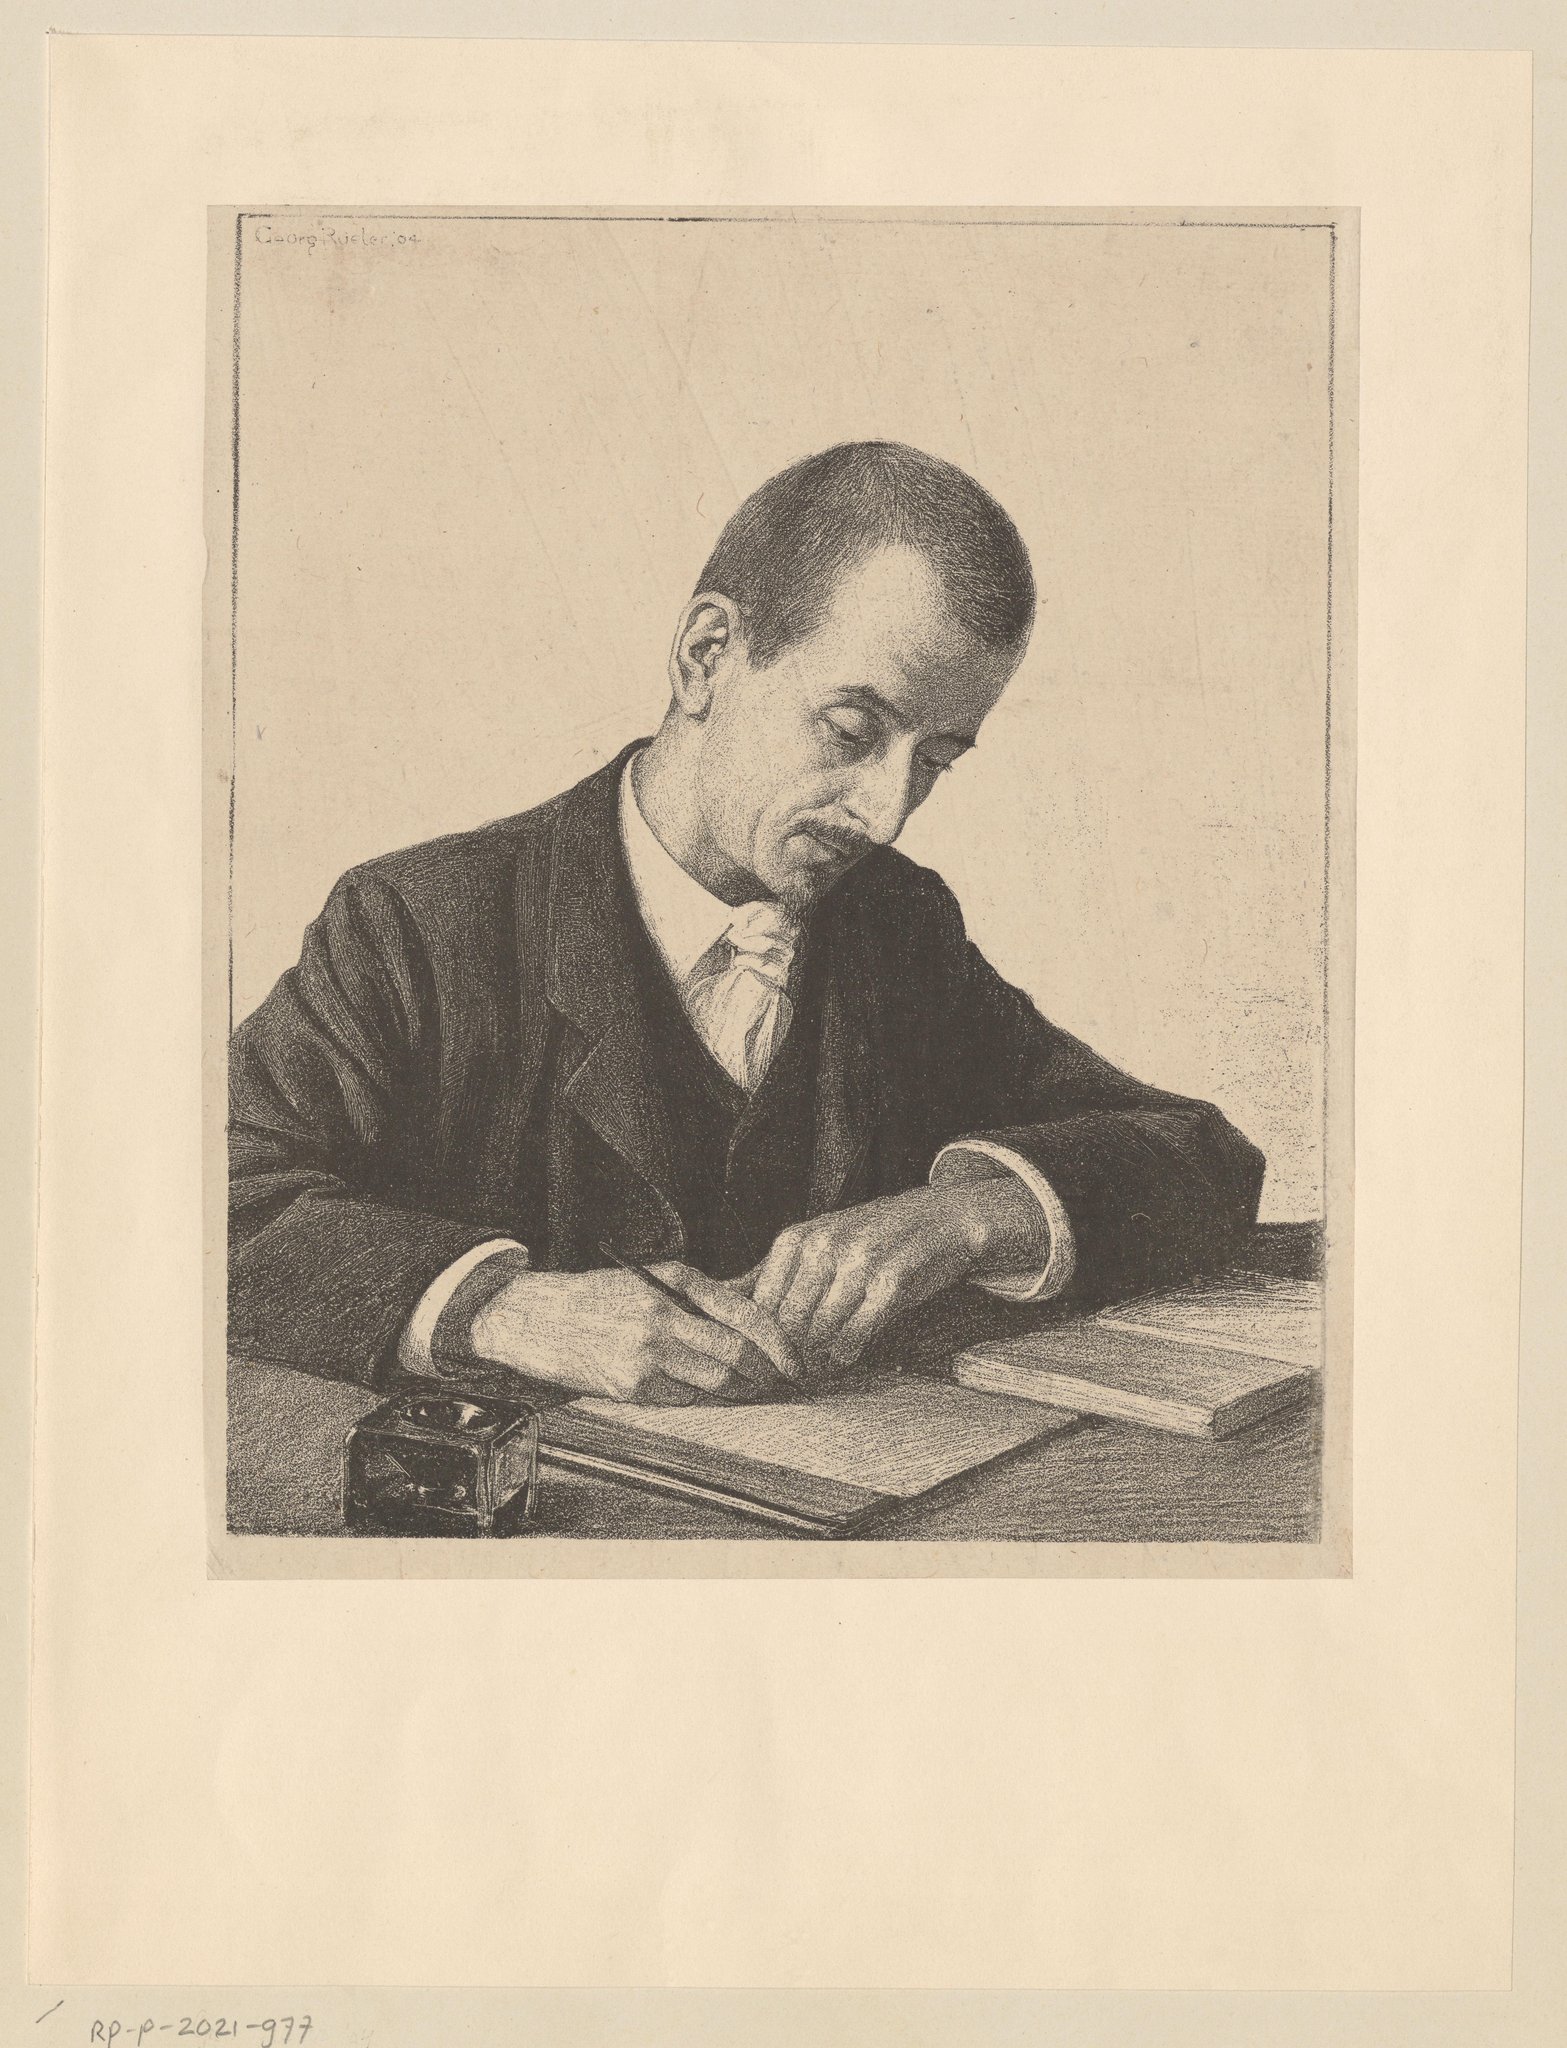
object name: print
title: Portret van Mathieu Lauweriks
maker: georg rueter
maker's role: draughtsman, painter, print maker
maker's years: 1875-1966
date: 1904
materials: paper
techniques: lithograph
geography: netherlands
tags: amsterdam, print maker, draughtsman, designer, mathieu lauweriks, handwriting, writing as activity, historical persons, portrait, self-portrait of artist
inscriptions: date